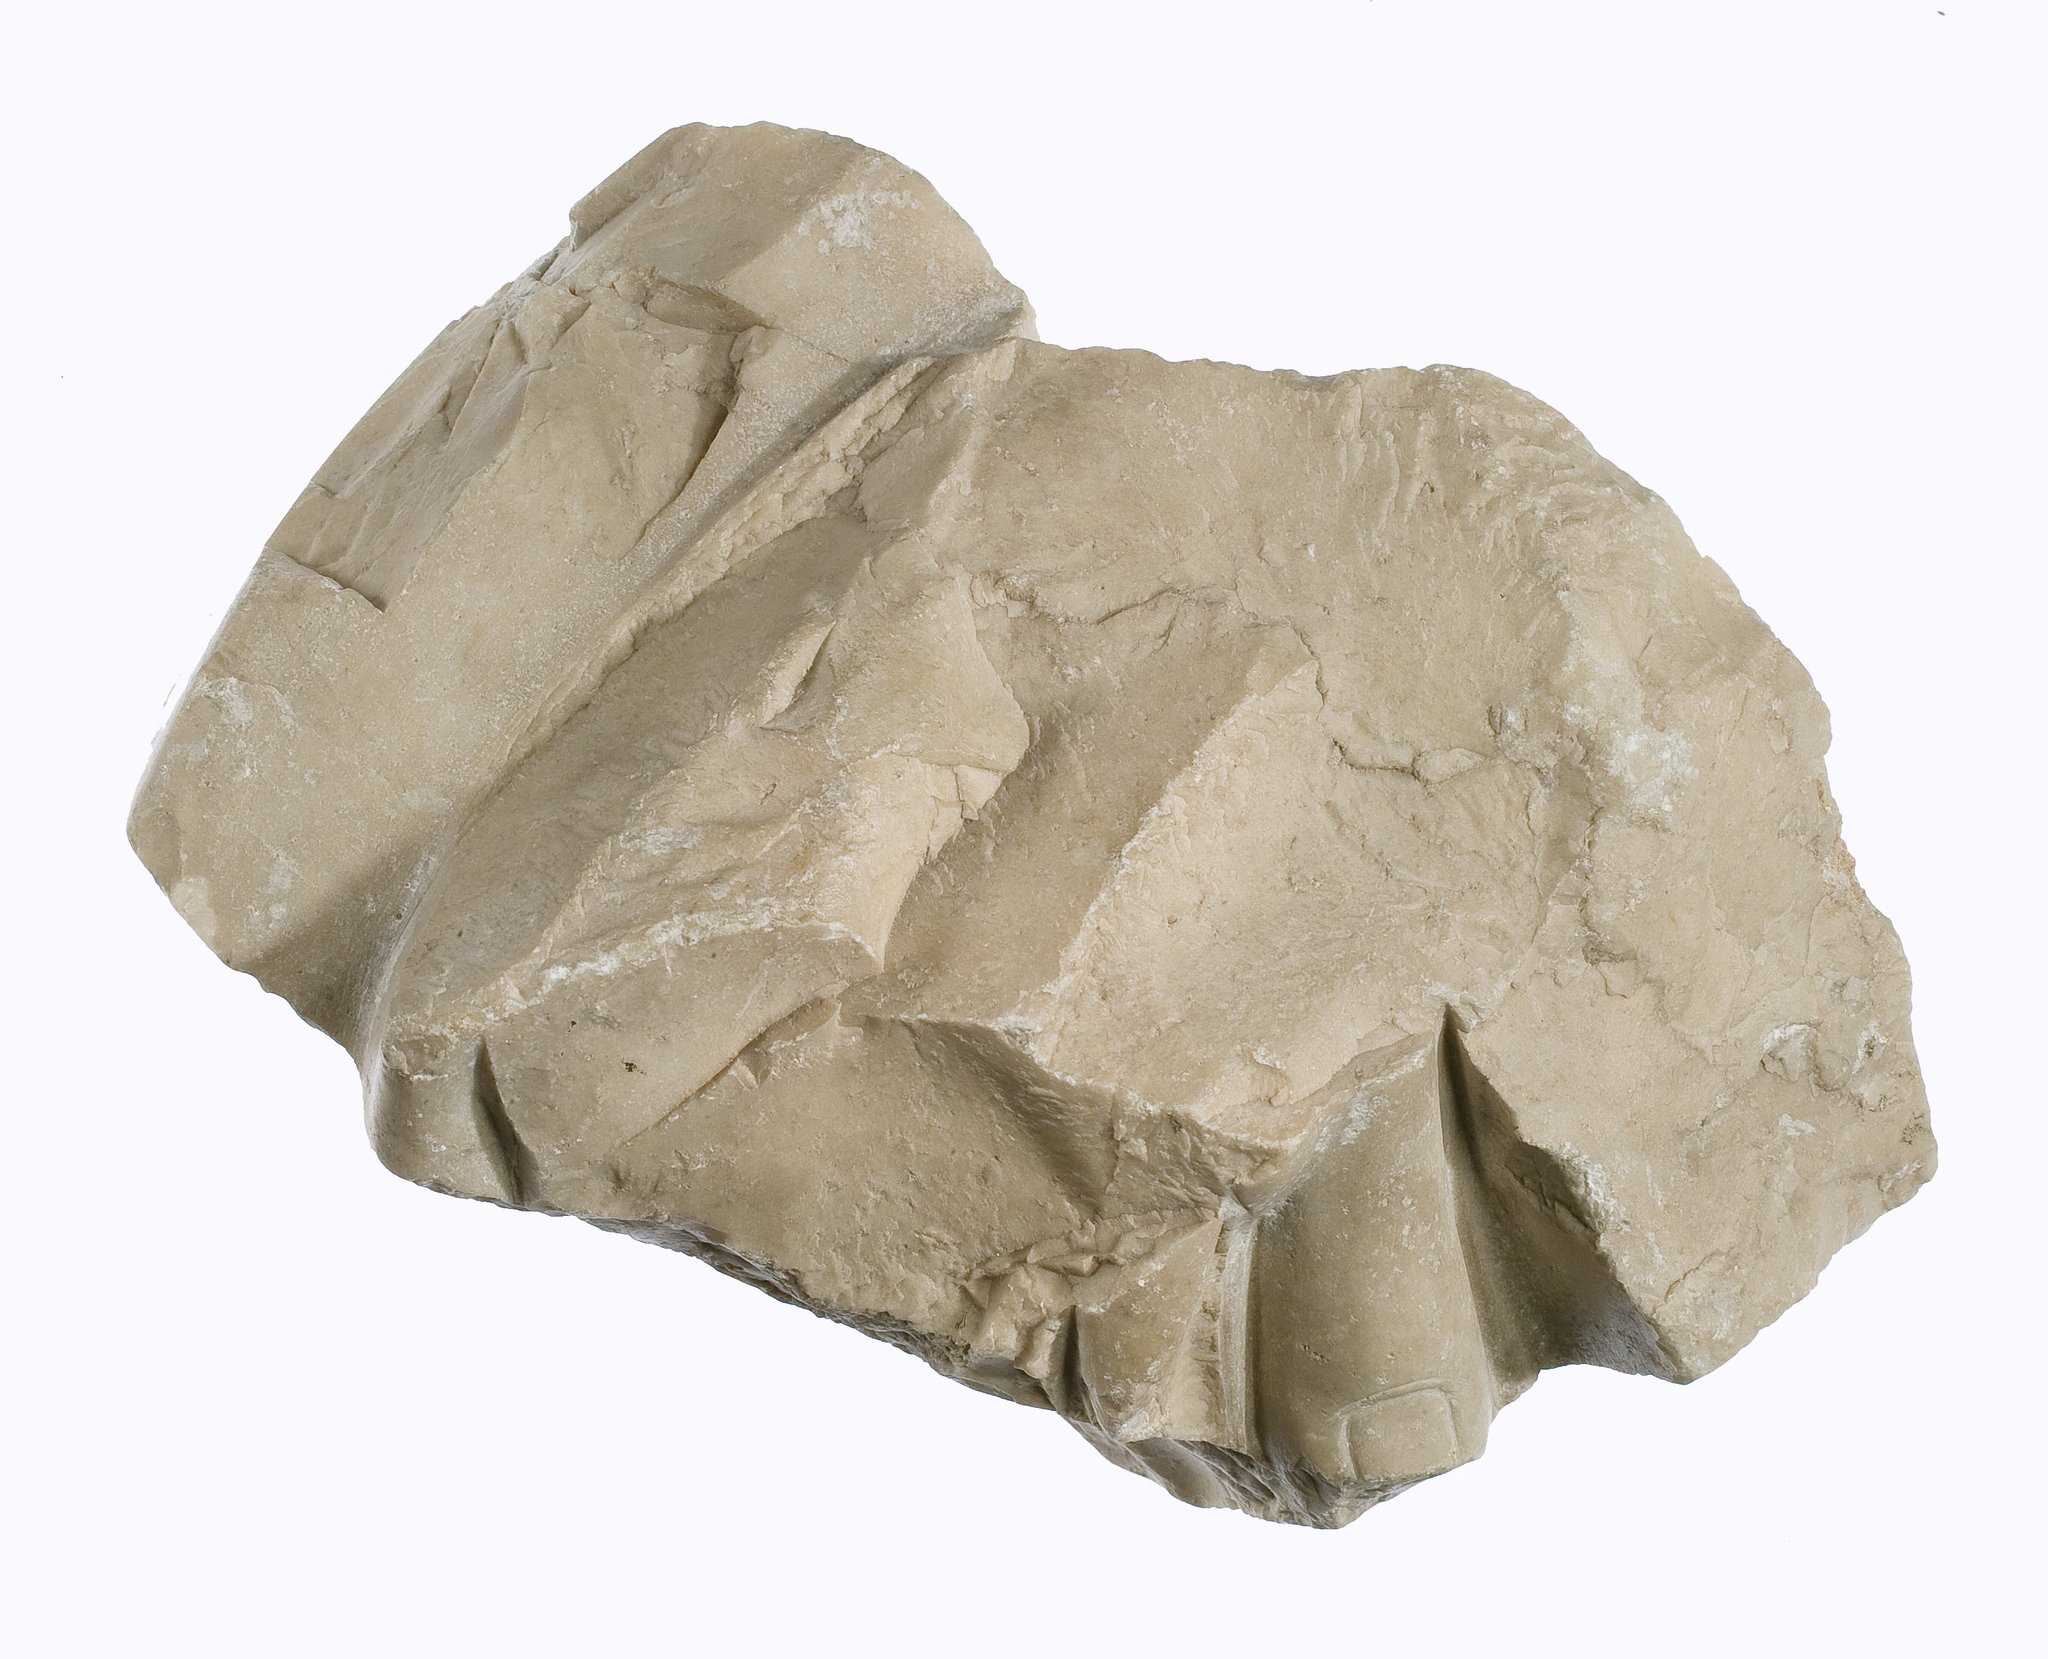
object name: akhenaten or nefertiti prostrate, foot leg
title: Foot of Akhenaten or Nefertiti prostrate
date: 1352-1336 BCE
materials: limestone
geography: egypt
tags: feet